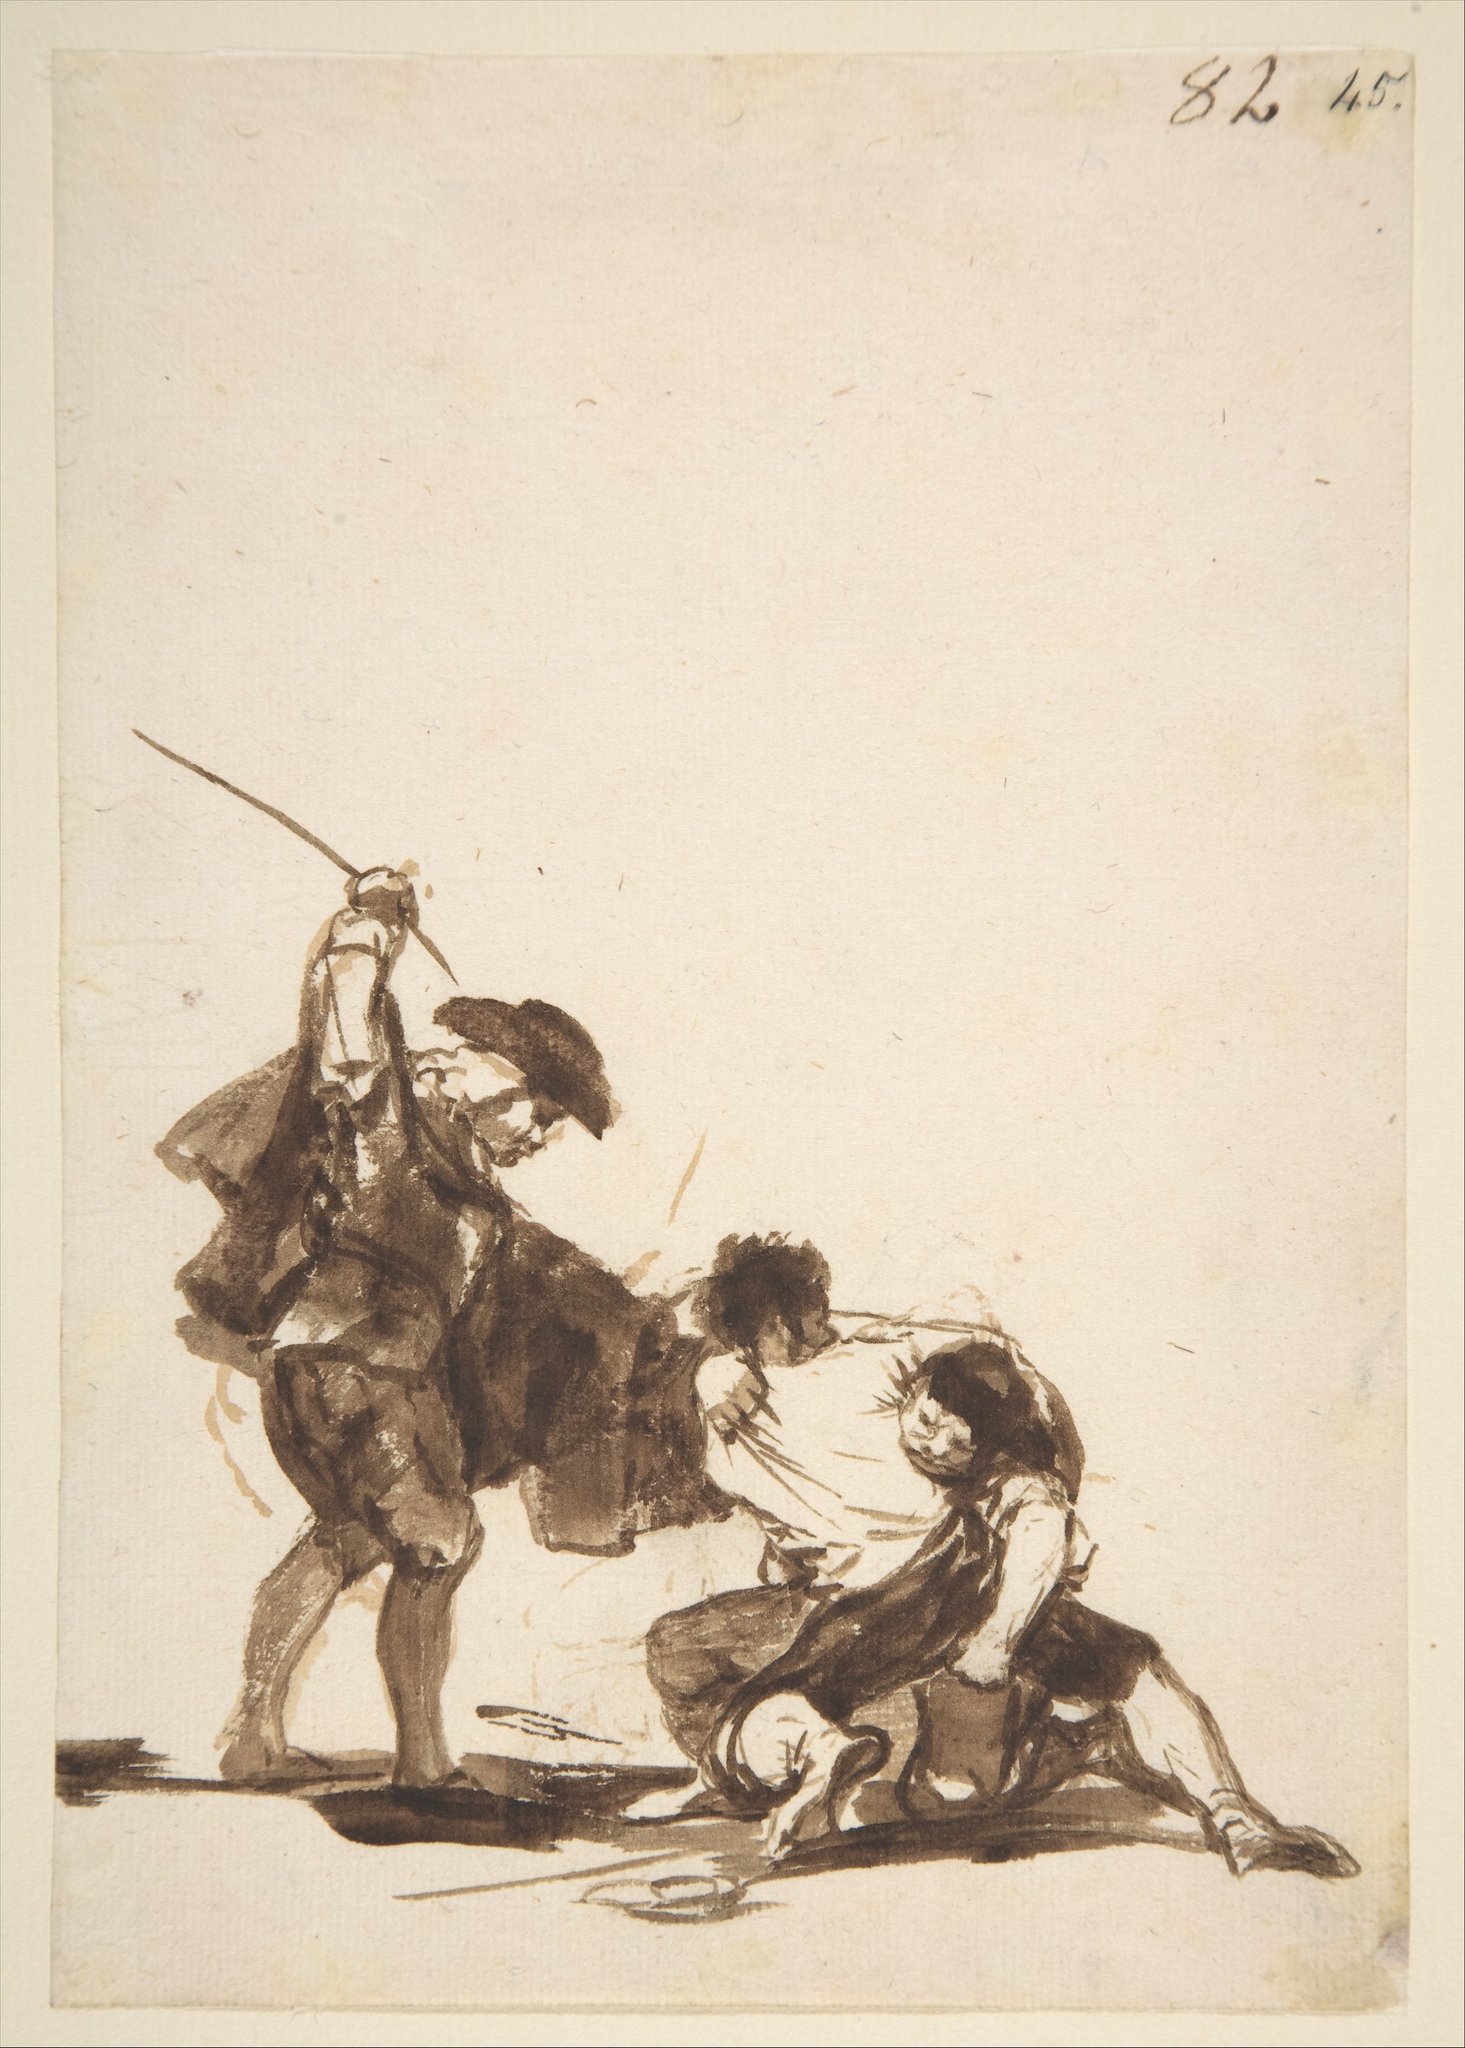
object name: drawing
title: A man breaking up a fight; page 82 from the "Images of Spain" Album (F)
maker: goya (francisco de goya y lucientes)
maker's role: artist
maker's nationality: spanish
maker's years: 1746-1828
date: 1812-1820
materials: chalk, ink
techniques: brush, wash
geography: spain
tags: men